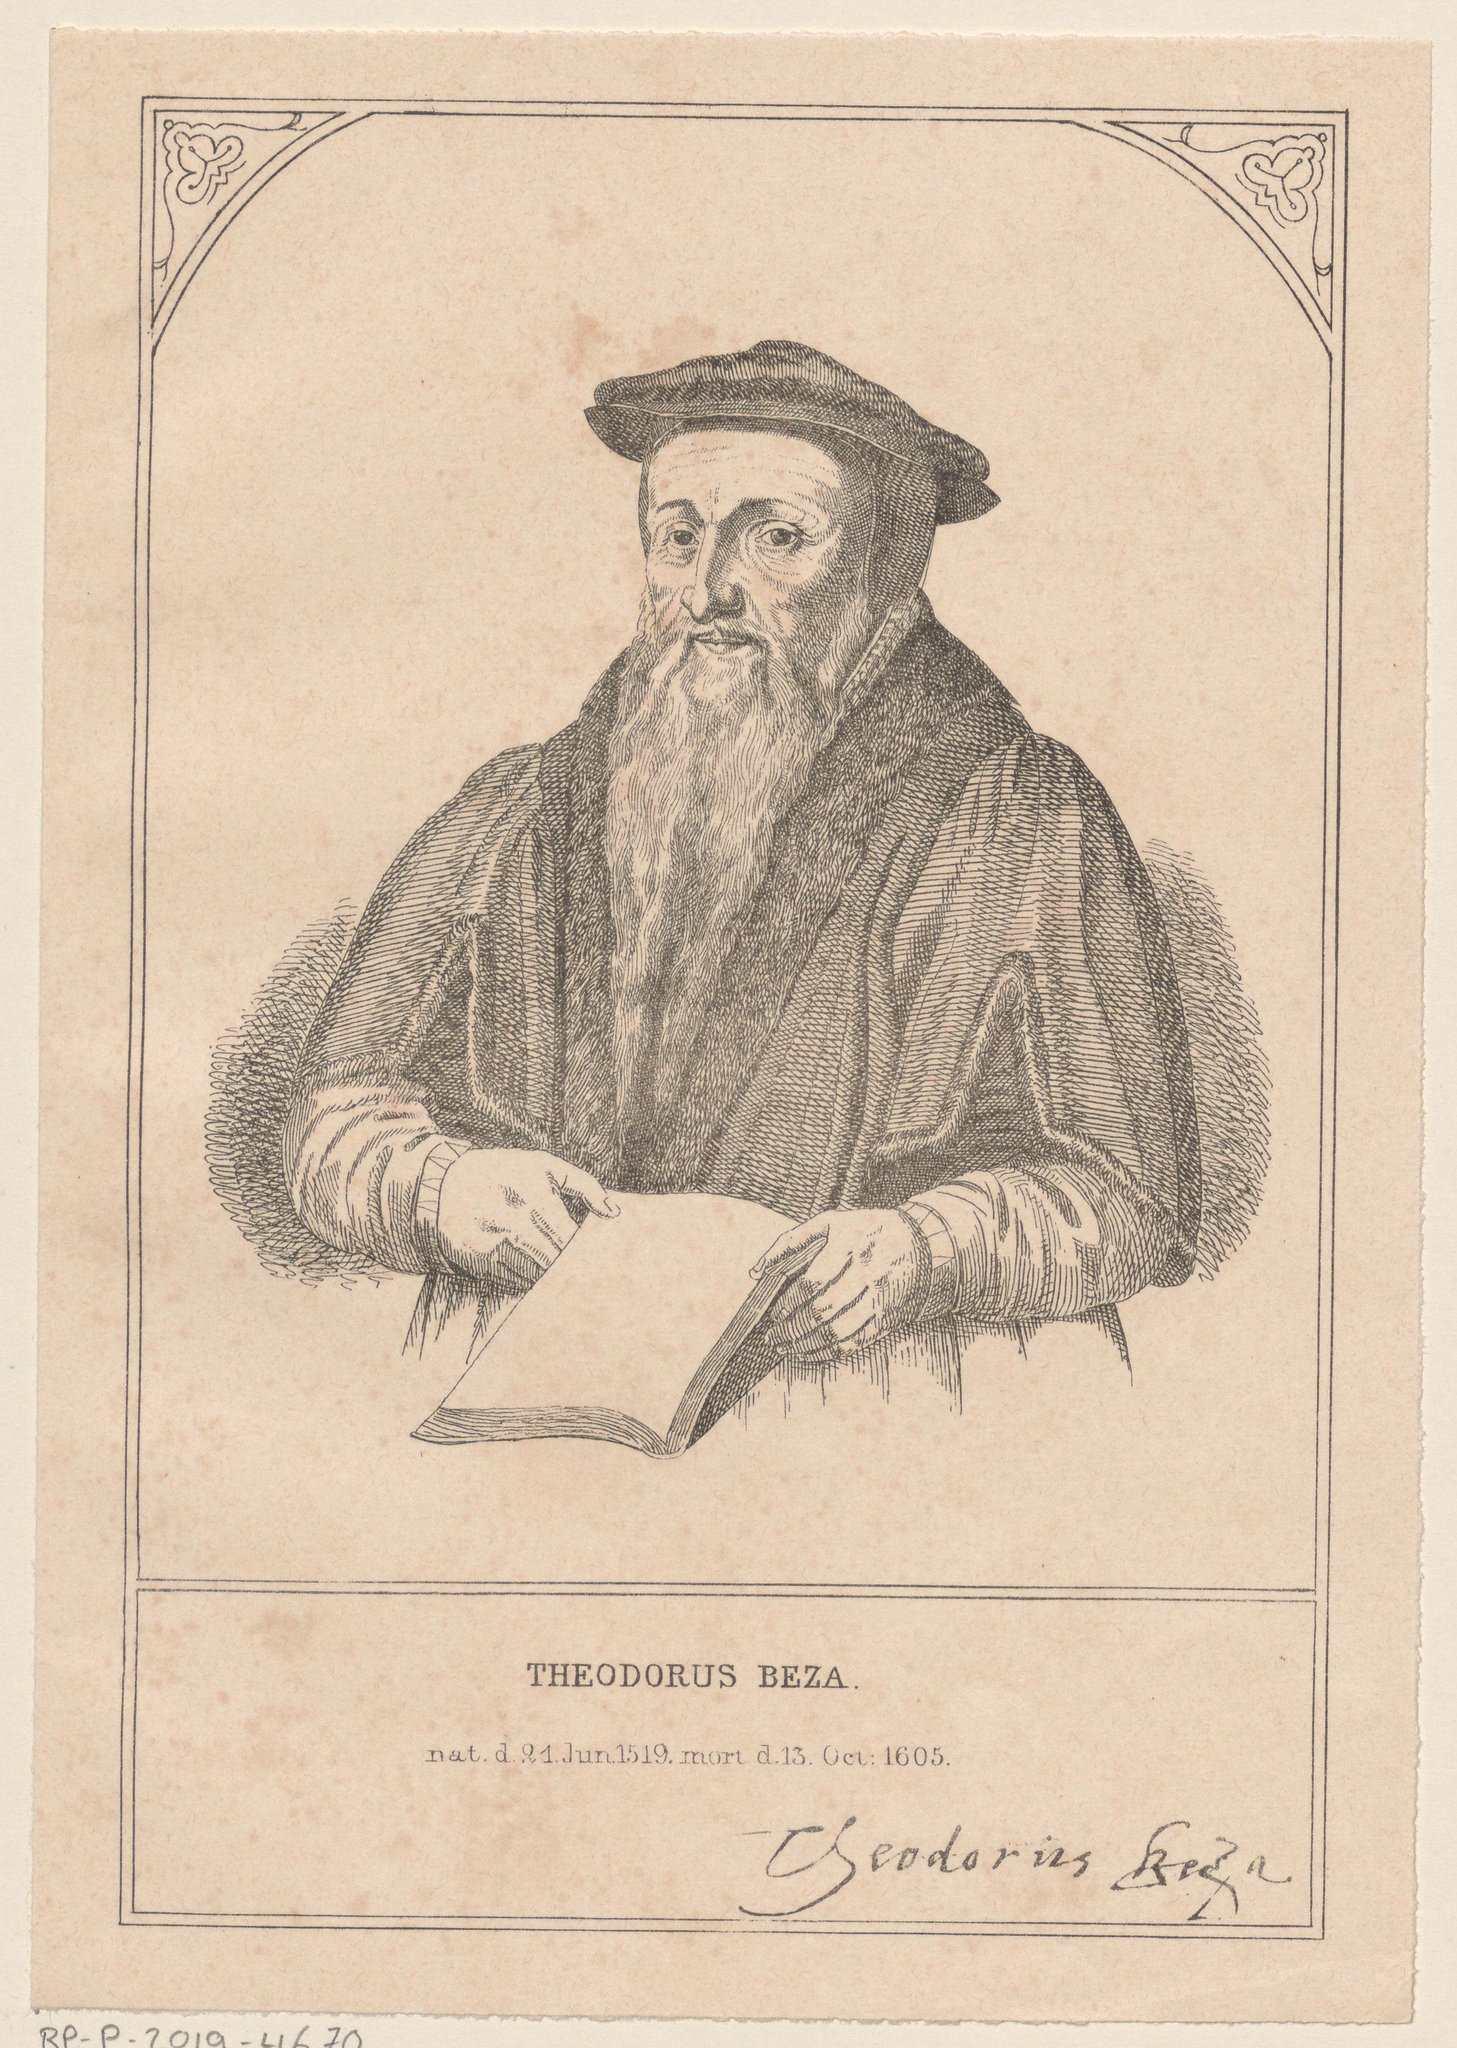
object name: print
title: Portret van Theodorus Beza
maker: Anonymous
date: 1800-1899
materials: paper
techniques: lithograph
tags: theodorus beza, theologian, historical persons, book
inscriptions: inscription: ‘Theodorus Beza’